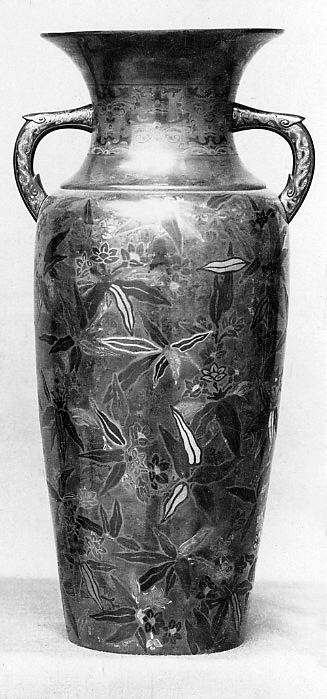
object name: vase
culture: japanese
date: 1801-1900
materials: silver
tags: flowers,leaves